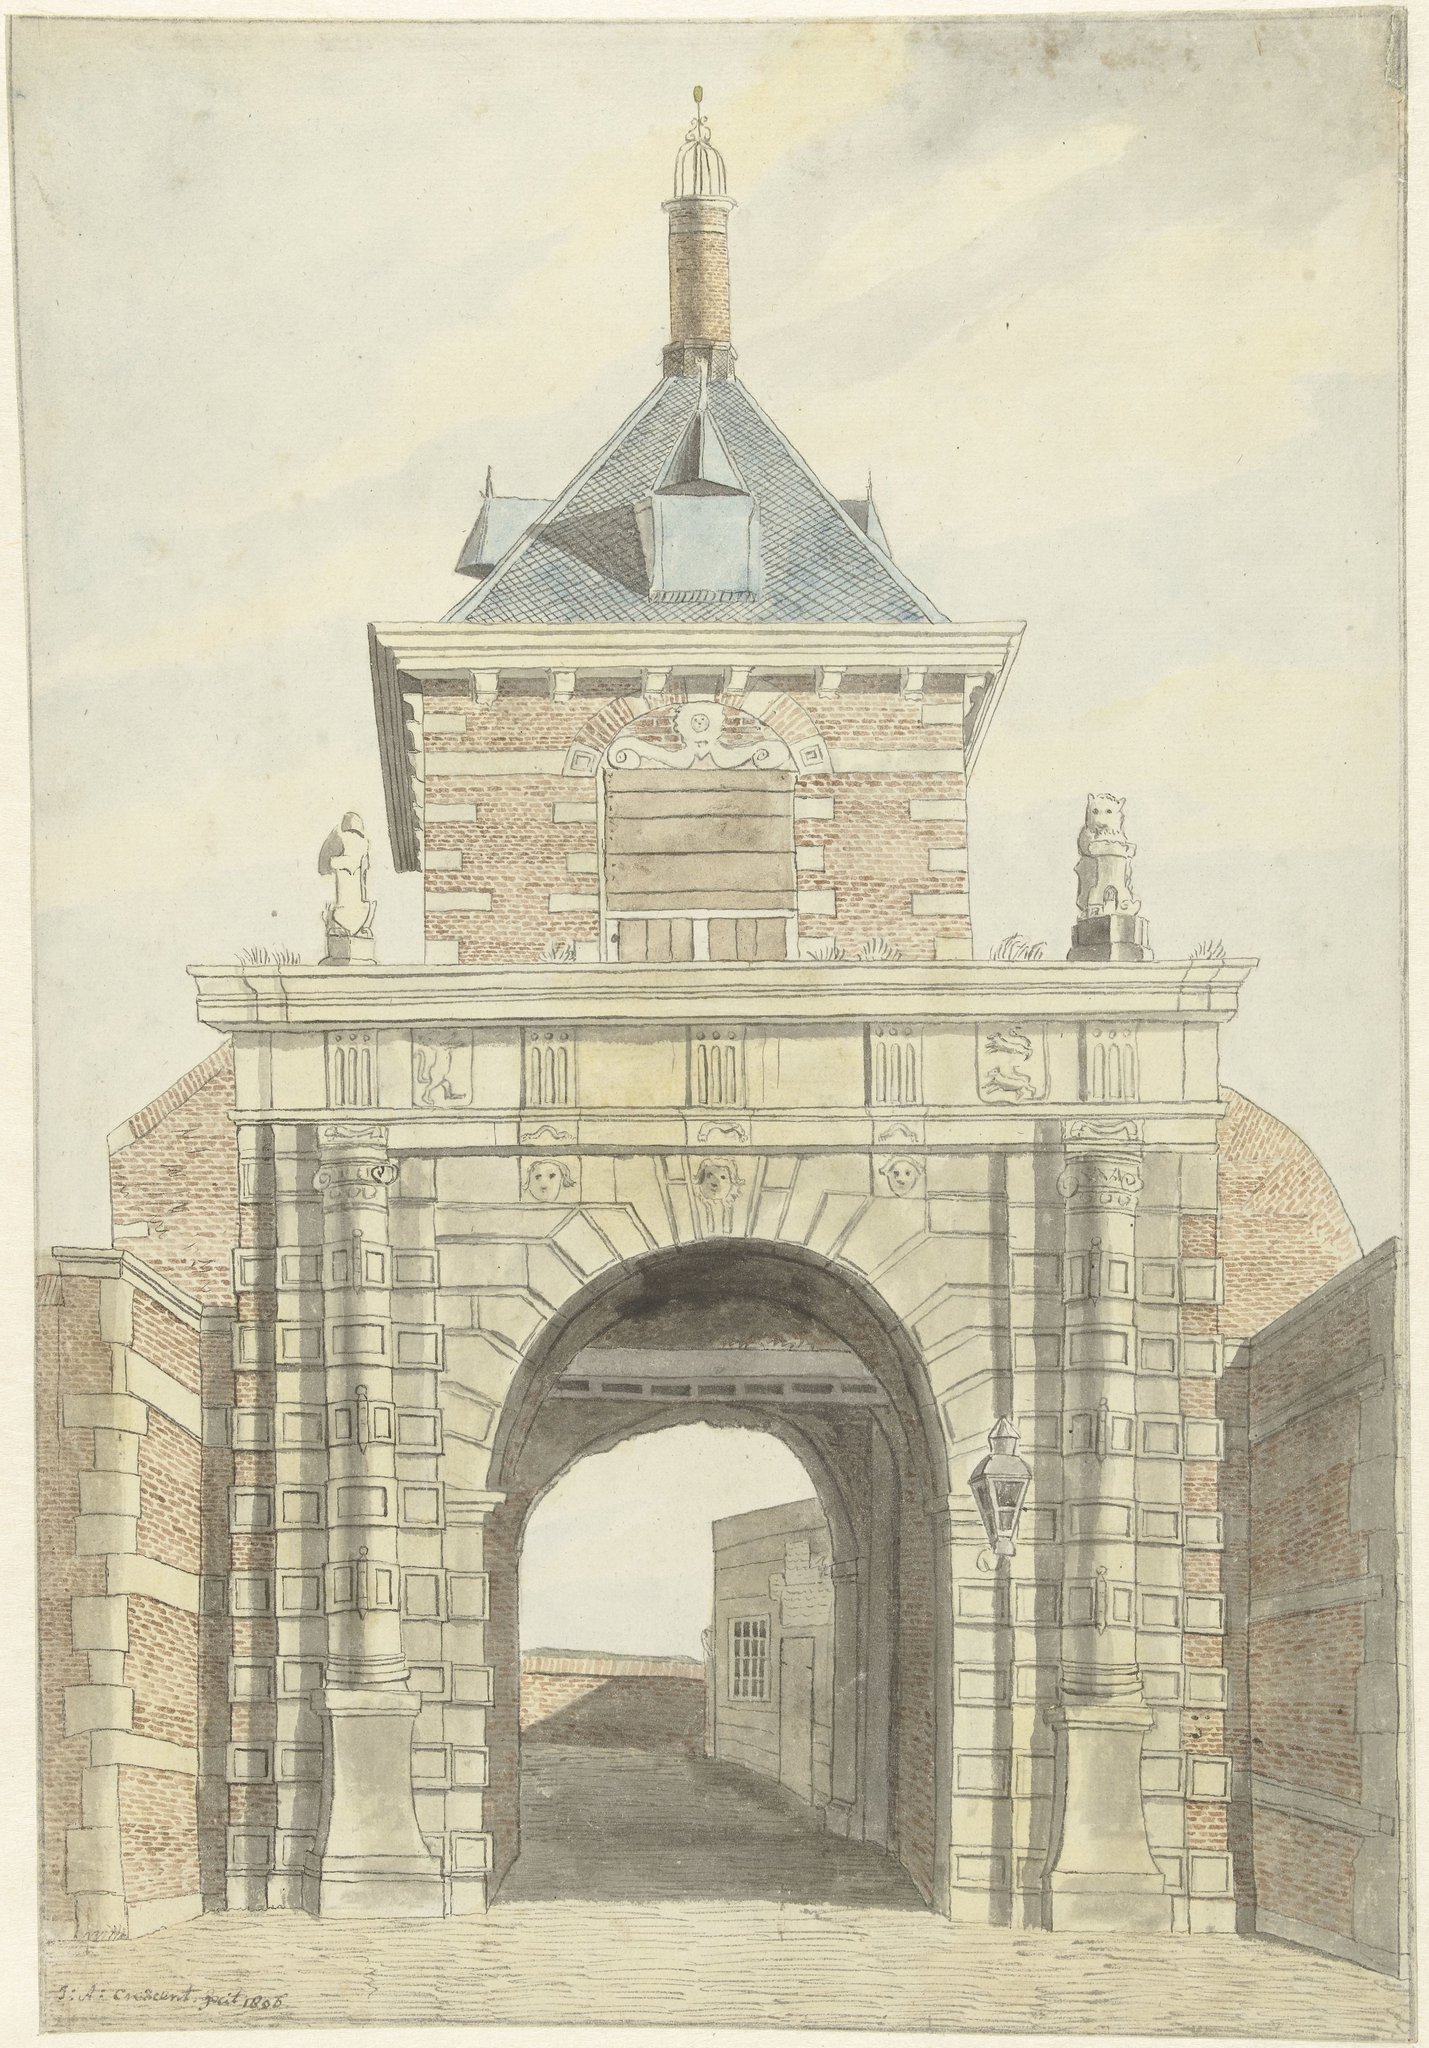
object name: watercolor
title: Gezicht op de oude Vriesche Poort te Alkmaar, van voren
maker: jacobus andreas crescent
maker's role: draughtsman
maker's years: 1768-1819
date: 1802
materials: chalk, ink, paper, watercolor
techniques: brush, pen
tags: city-gate